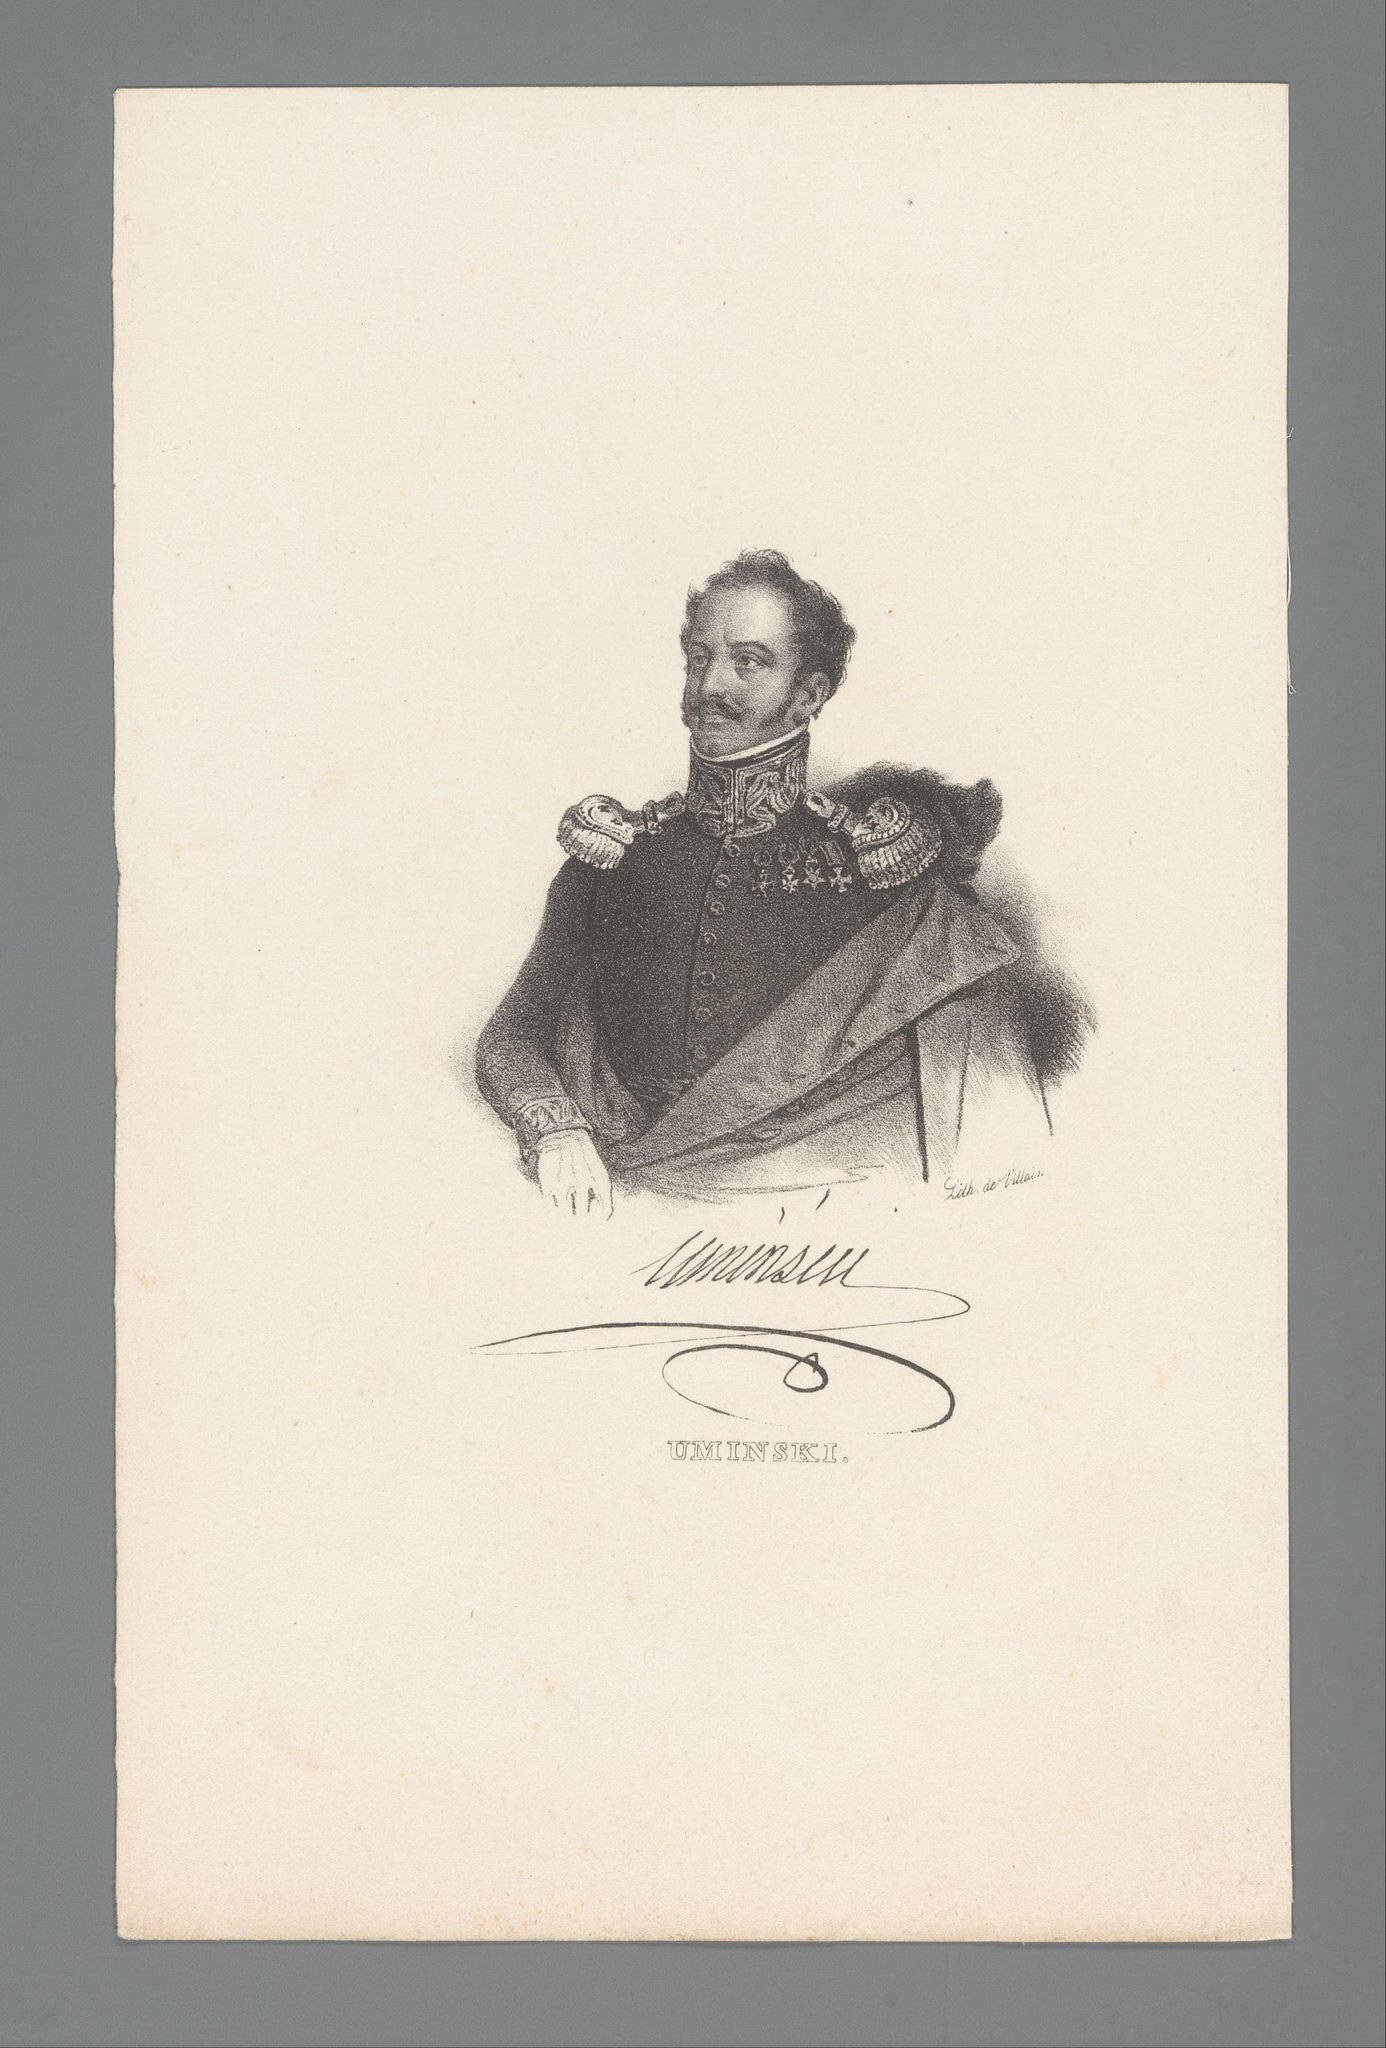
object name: book illustration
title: Portret van Jan Nepomucen Umiński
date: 1832-1839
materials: paper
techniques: lithograph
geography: paris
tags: historical persons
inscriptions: collector's mark: Lugt 2228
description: Prent uit: Straszewicz., Joseph. Les polonais et les polonaises de la révolution du 29 novembre 1830, ou Portraits des personnes qui ont figuré dans la dernière guerre de l'indépendance polonaise, avec les fac-simile de leur signature, lithographiés sur dessins originaux, par les artistes les plus distingués: MM. Grévedon, Maurin, Vigneron, Belliard, Devéria, Bazin, Desmadryl, Lecler, Desmaisons, Rutowski, officier polonais, etc,. etc., accompagnés d'une biographie pour chaque portrait. Parijs: Catherine-Anaïs Pinard, 1832. Of uit: Straszewicz., Joseph. Les polonais et les polonaises de la révolution du 29 novembre 1830. Biographie des personnes qui ont figuré dans la dernière guerre de l'indépendance polonaise, avec les fac-simile de leur signature, ornée de 30 portraits lithographiés sur dessins originaux, par les artistes les plus distingués: MM. Grévedon, Maurin, Vigneron, Belliard, Devéria, Bazin, Desmadryl, Lecler, etc., etc.. Parijs: s.n., 1839.